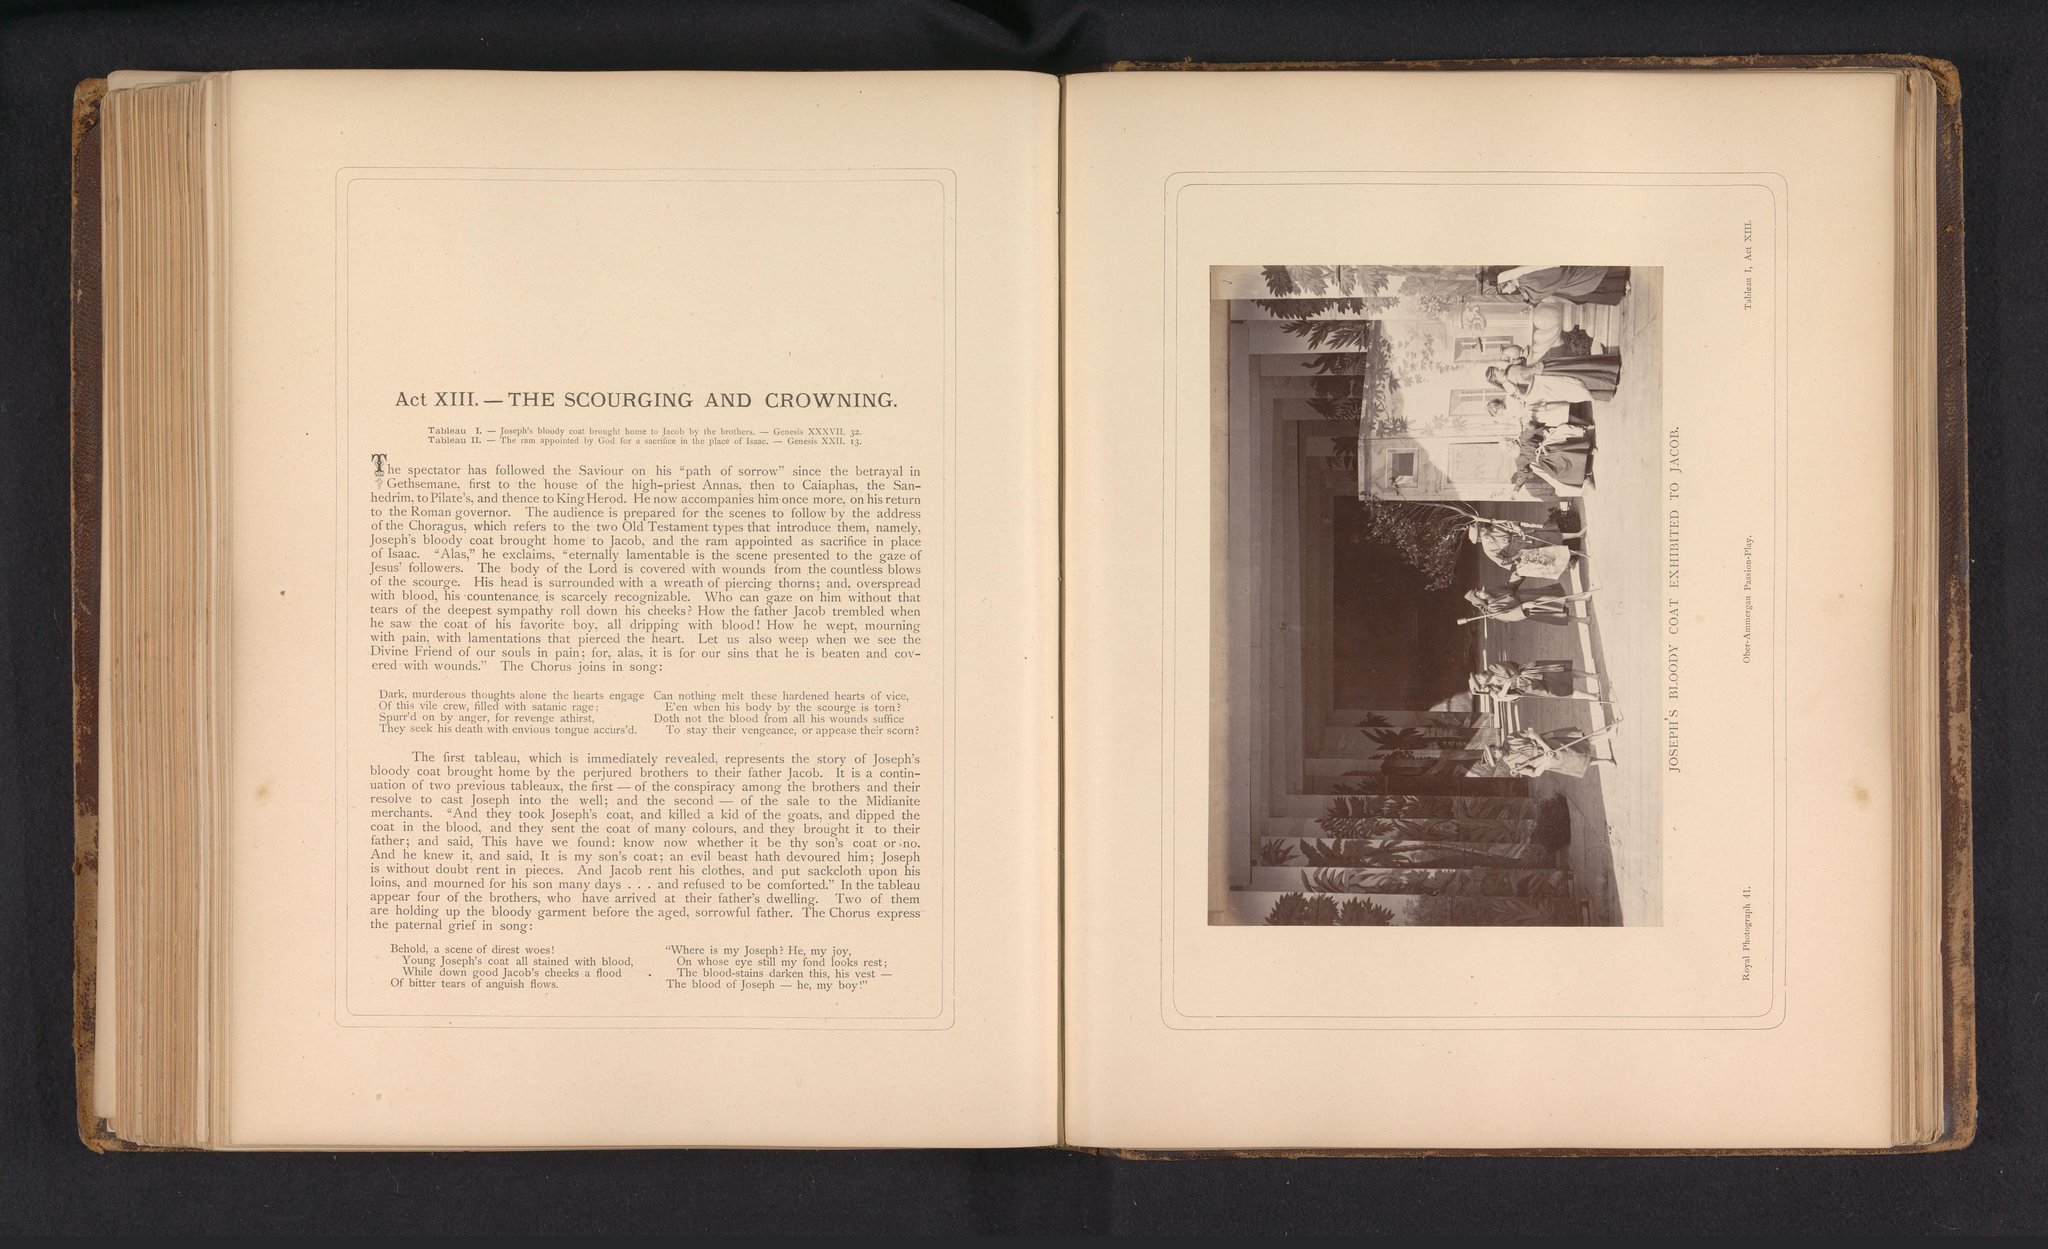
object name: page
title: Joseph's bloody coat exhibited to Jacob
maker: joseph albert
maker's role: printer, publisher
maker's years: 1825-1886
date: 1868-1873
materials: photographic support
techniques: albumen print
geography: oberammergau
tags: group of actors, troupe; actors on the stage, joseph's blood-stained coat is brought and shown to jacob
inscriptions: number: ‘Royal Photograph 41.’